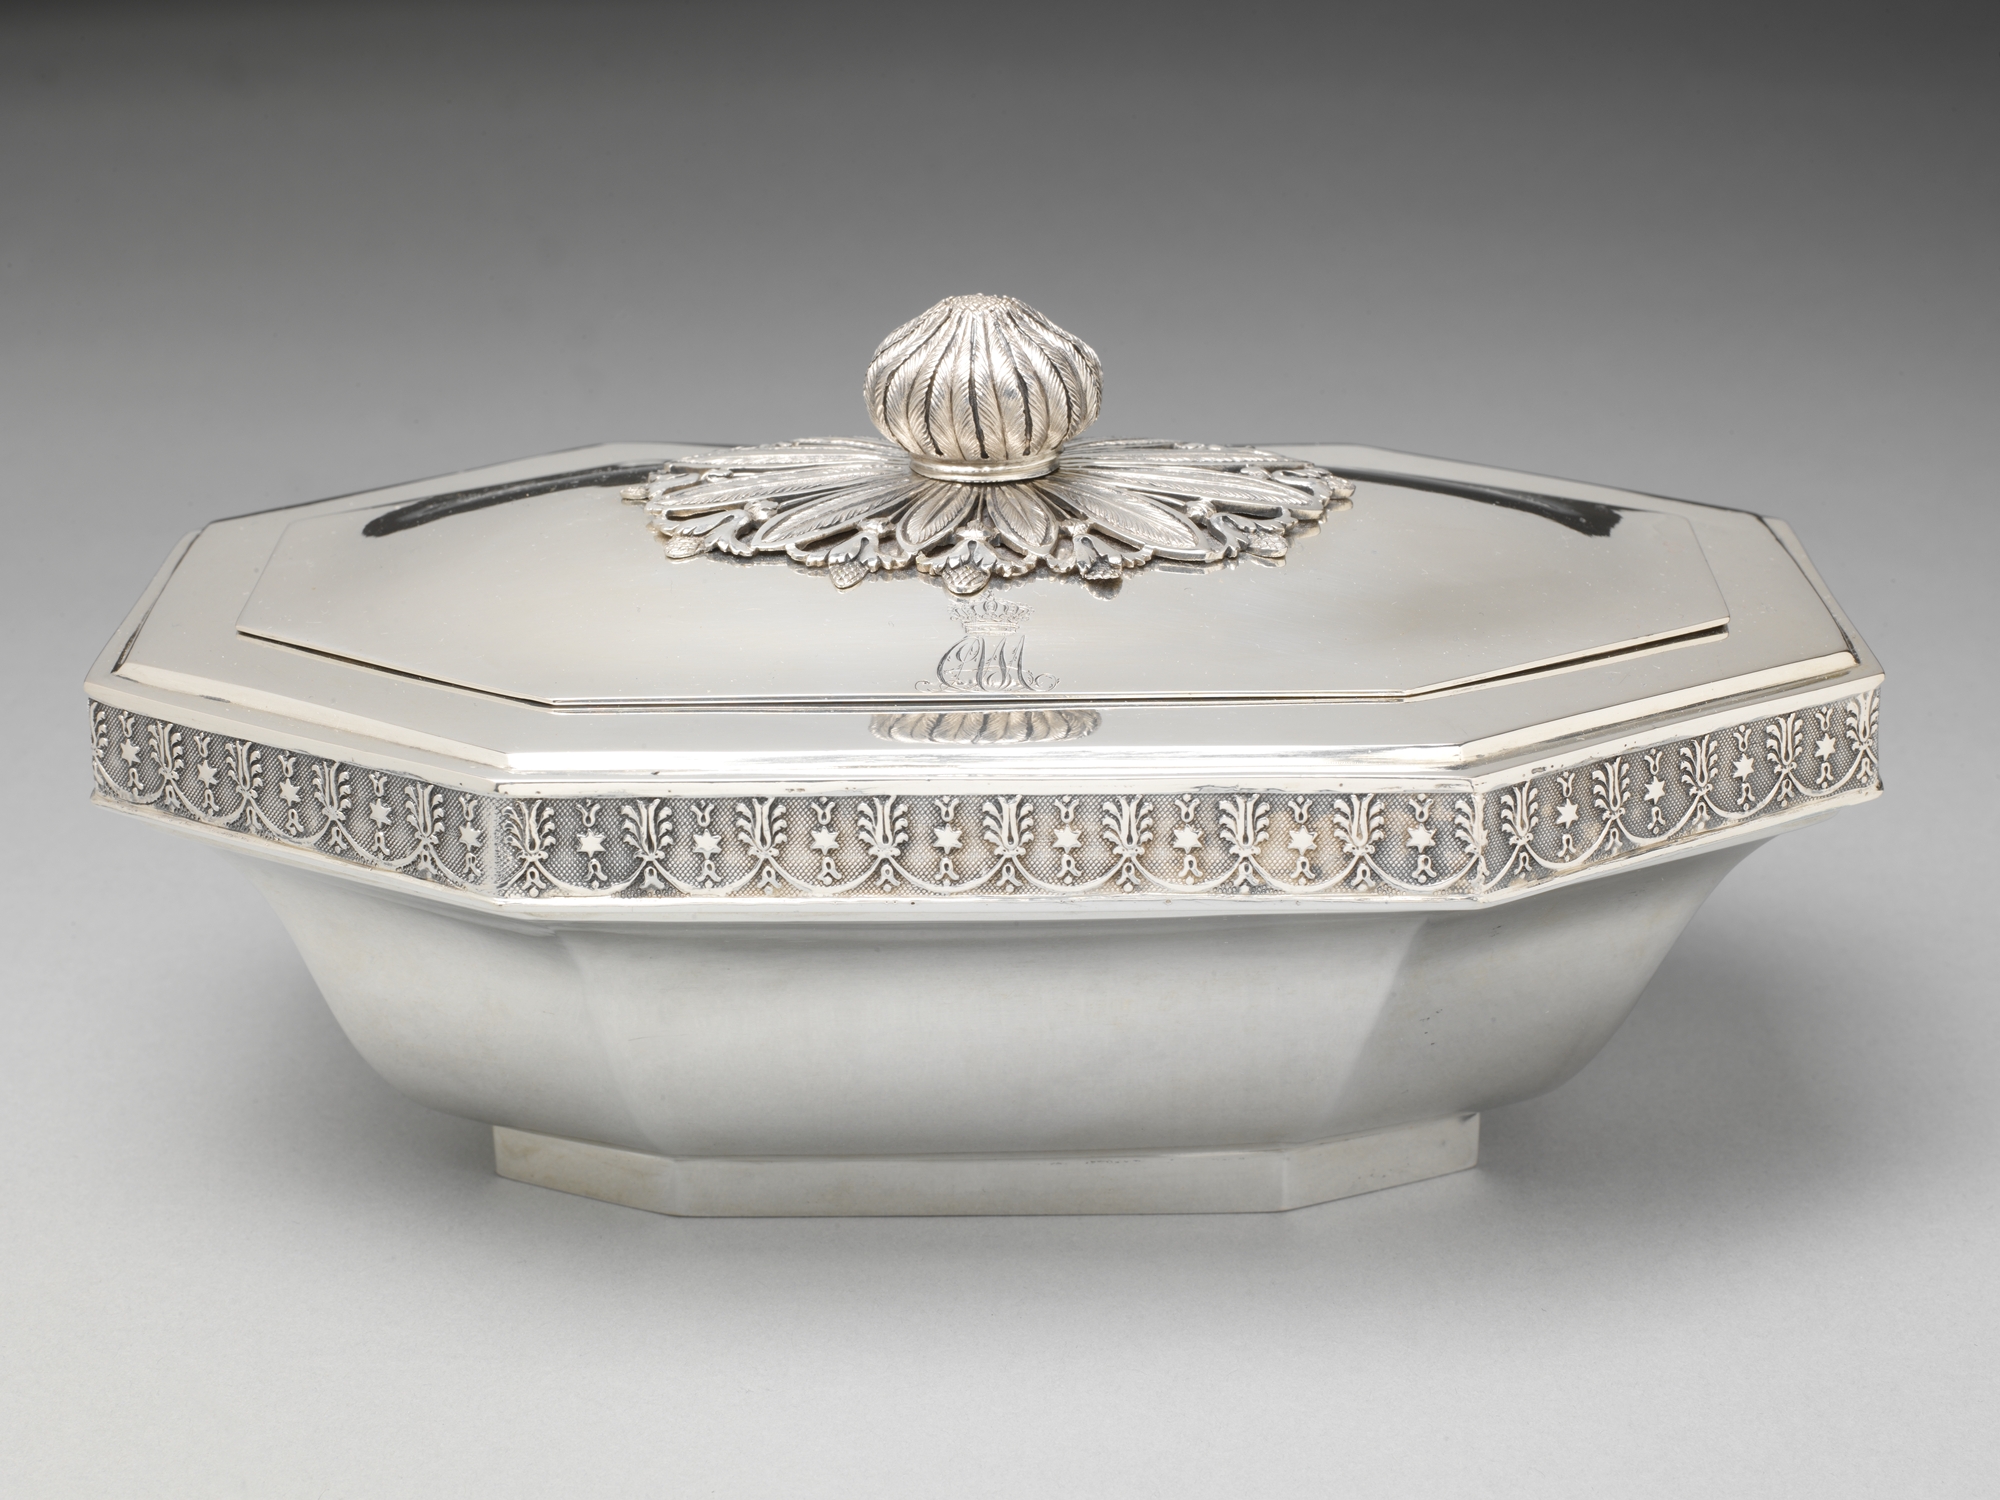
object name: box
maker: johann christian sick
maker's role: maker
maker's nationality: german (stuttgart)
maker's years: 1766-1824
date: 1800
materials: silver